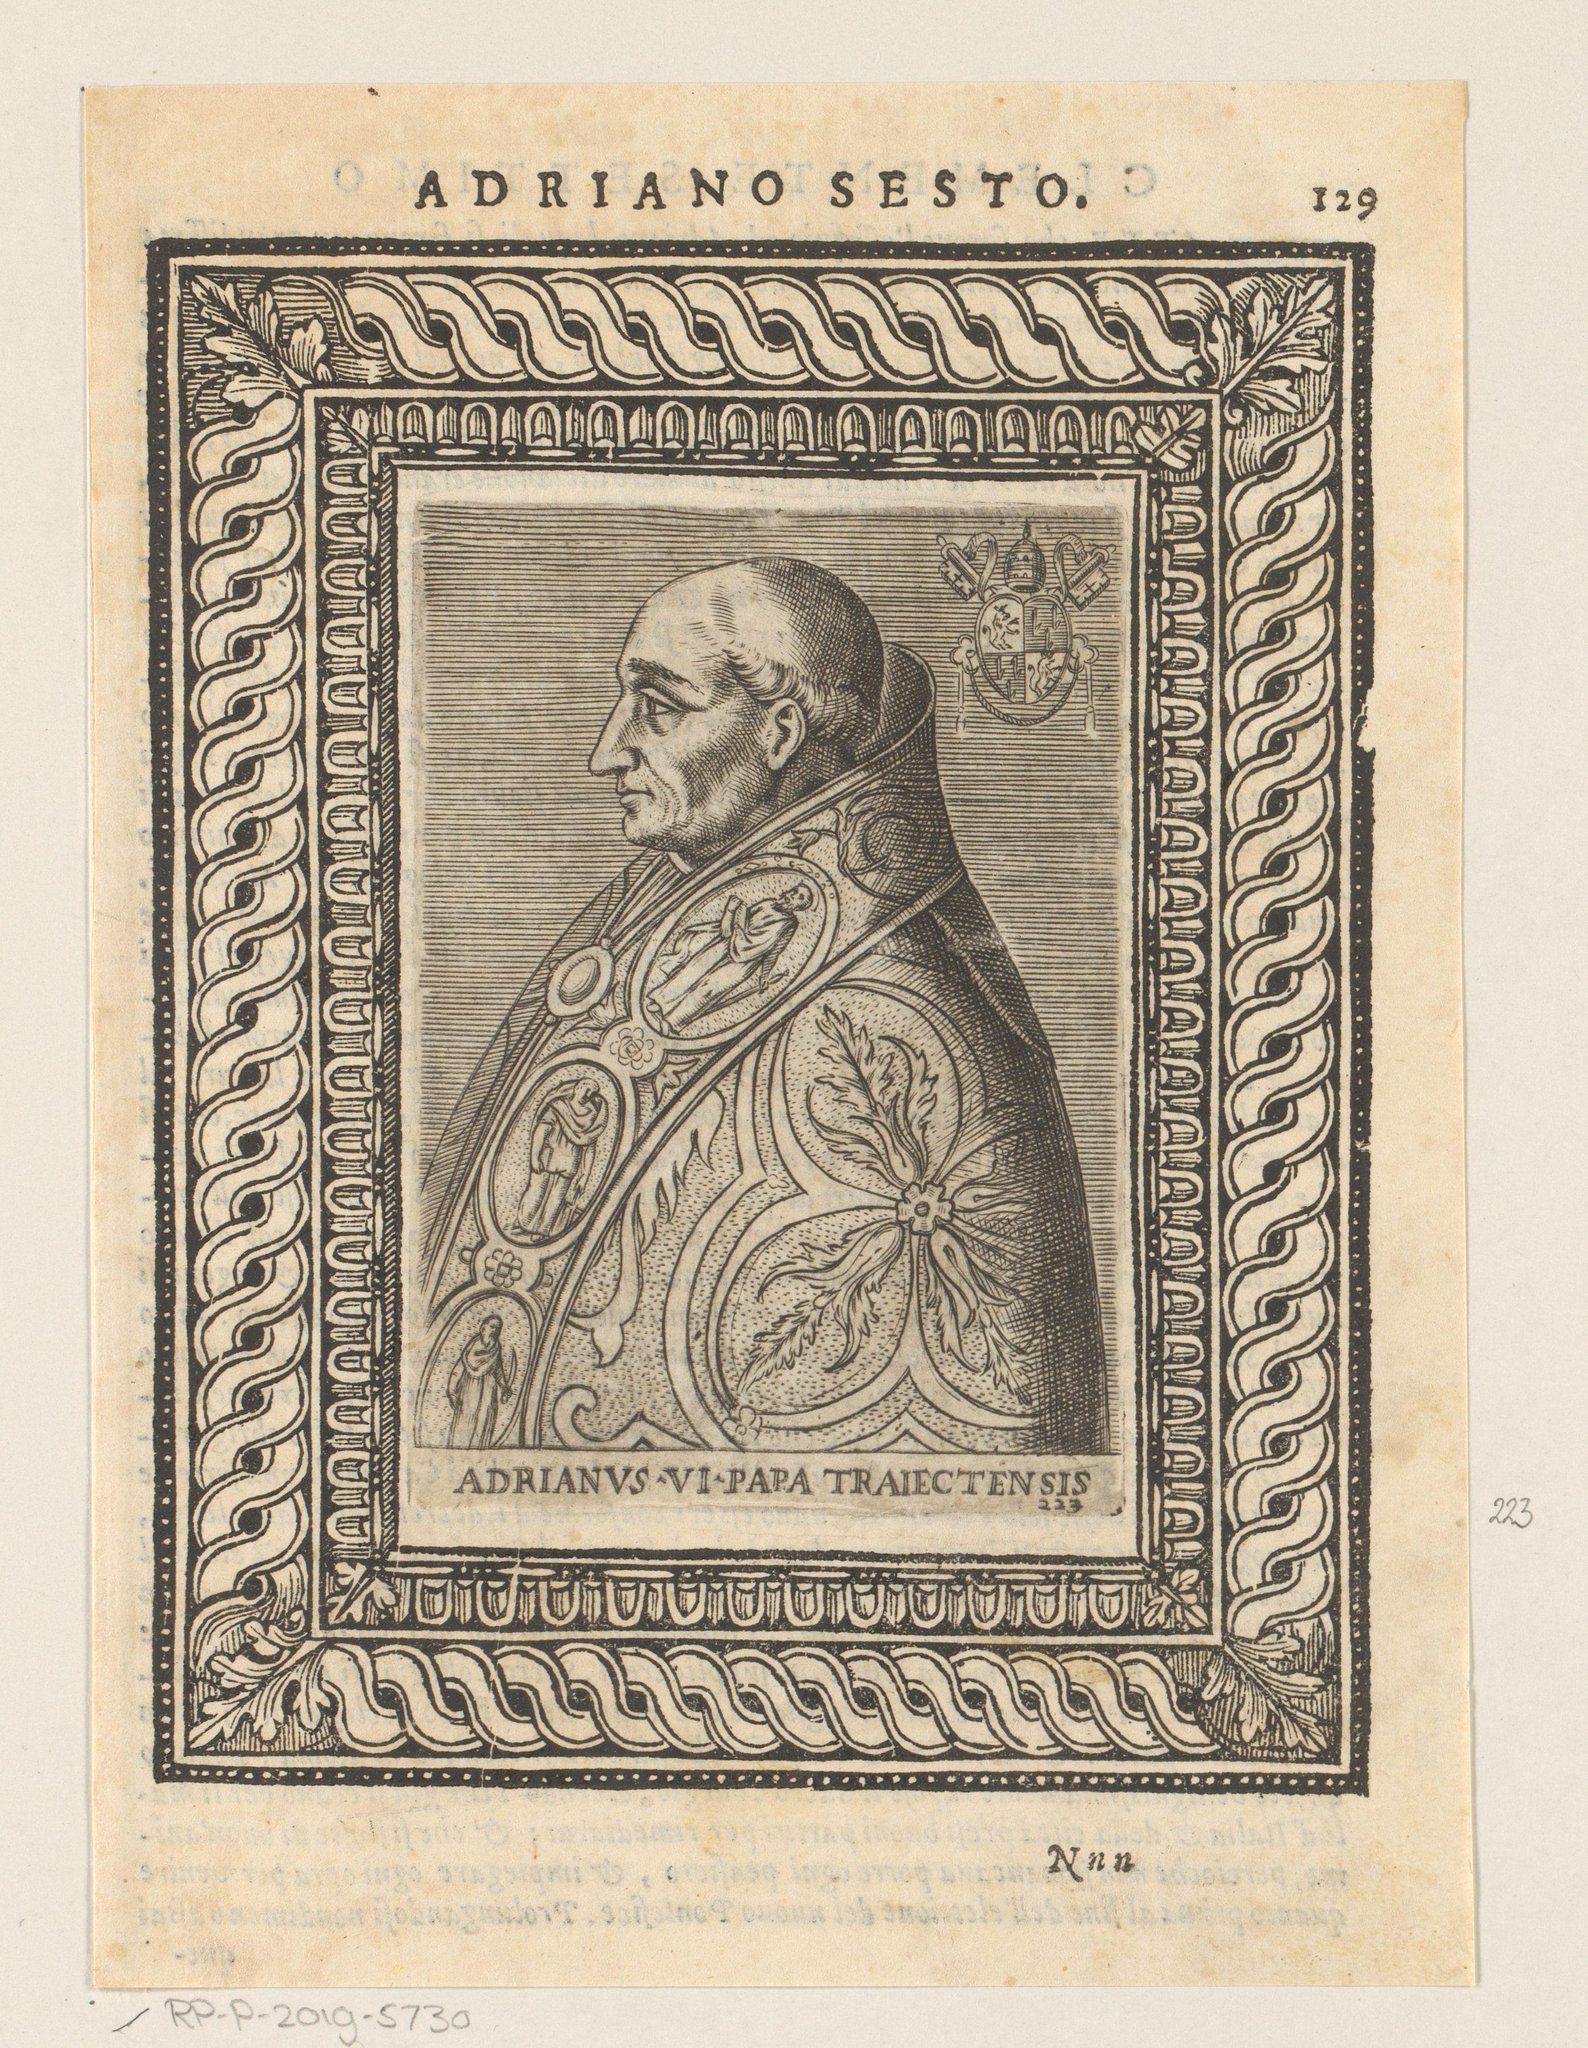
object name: book illustration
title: Portret van paus Adrianus VI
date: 1587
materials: paper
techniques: engraving, letterpress printing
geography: rome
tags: utrecht, rome, historical persons, pope, armorial bearing, heraldry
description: Prent uit: Ciccarelli, Antonio. Le vite de Pontefici di Antonio Ciccarelli (...). Rome: Domenico Basa, 1587. Prent voor het eerst verschenen in: Cavalieri, Giovanni Battista de'. Pontificum romanorum effigies (...). Rome: Domenico Basa en Francesco Zanetti, 1580. Prent ook gebruikt in latere publicaties.